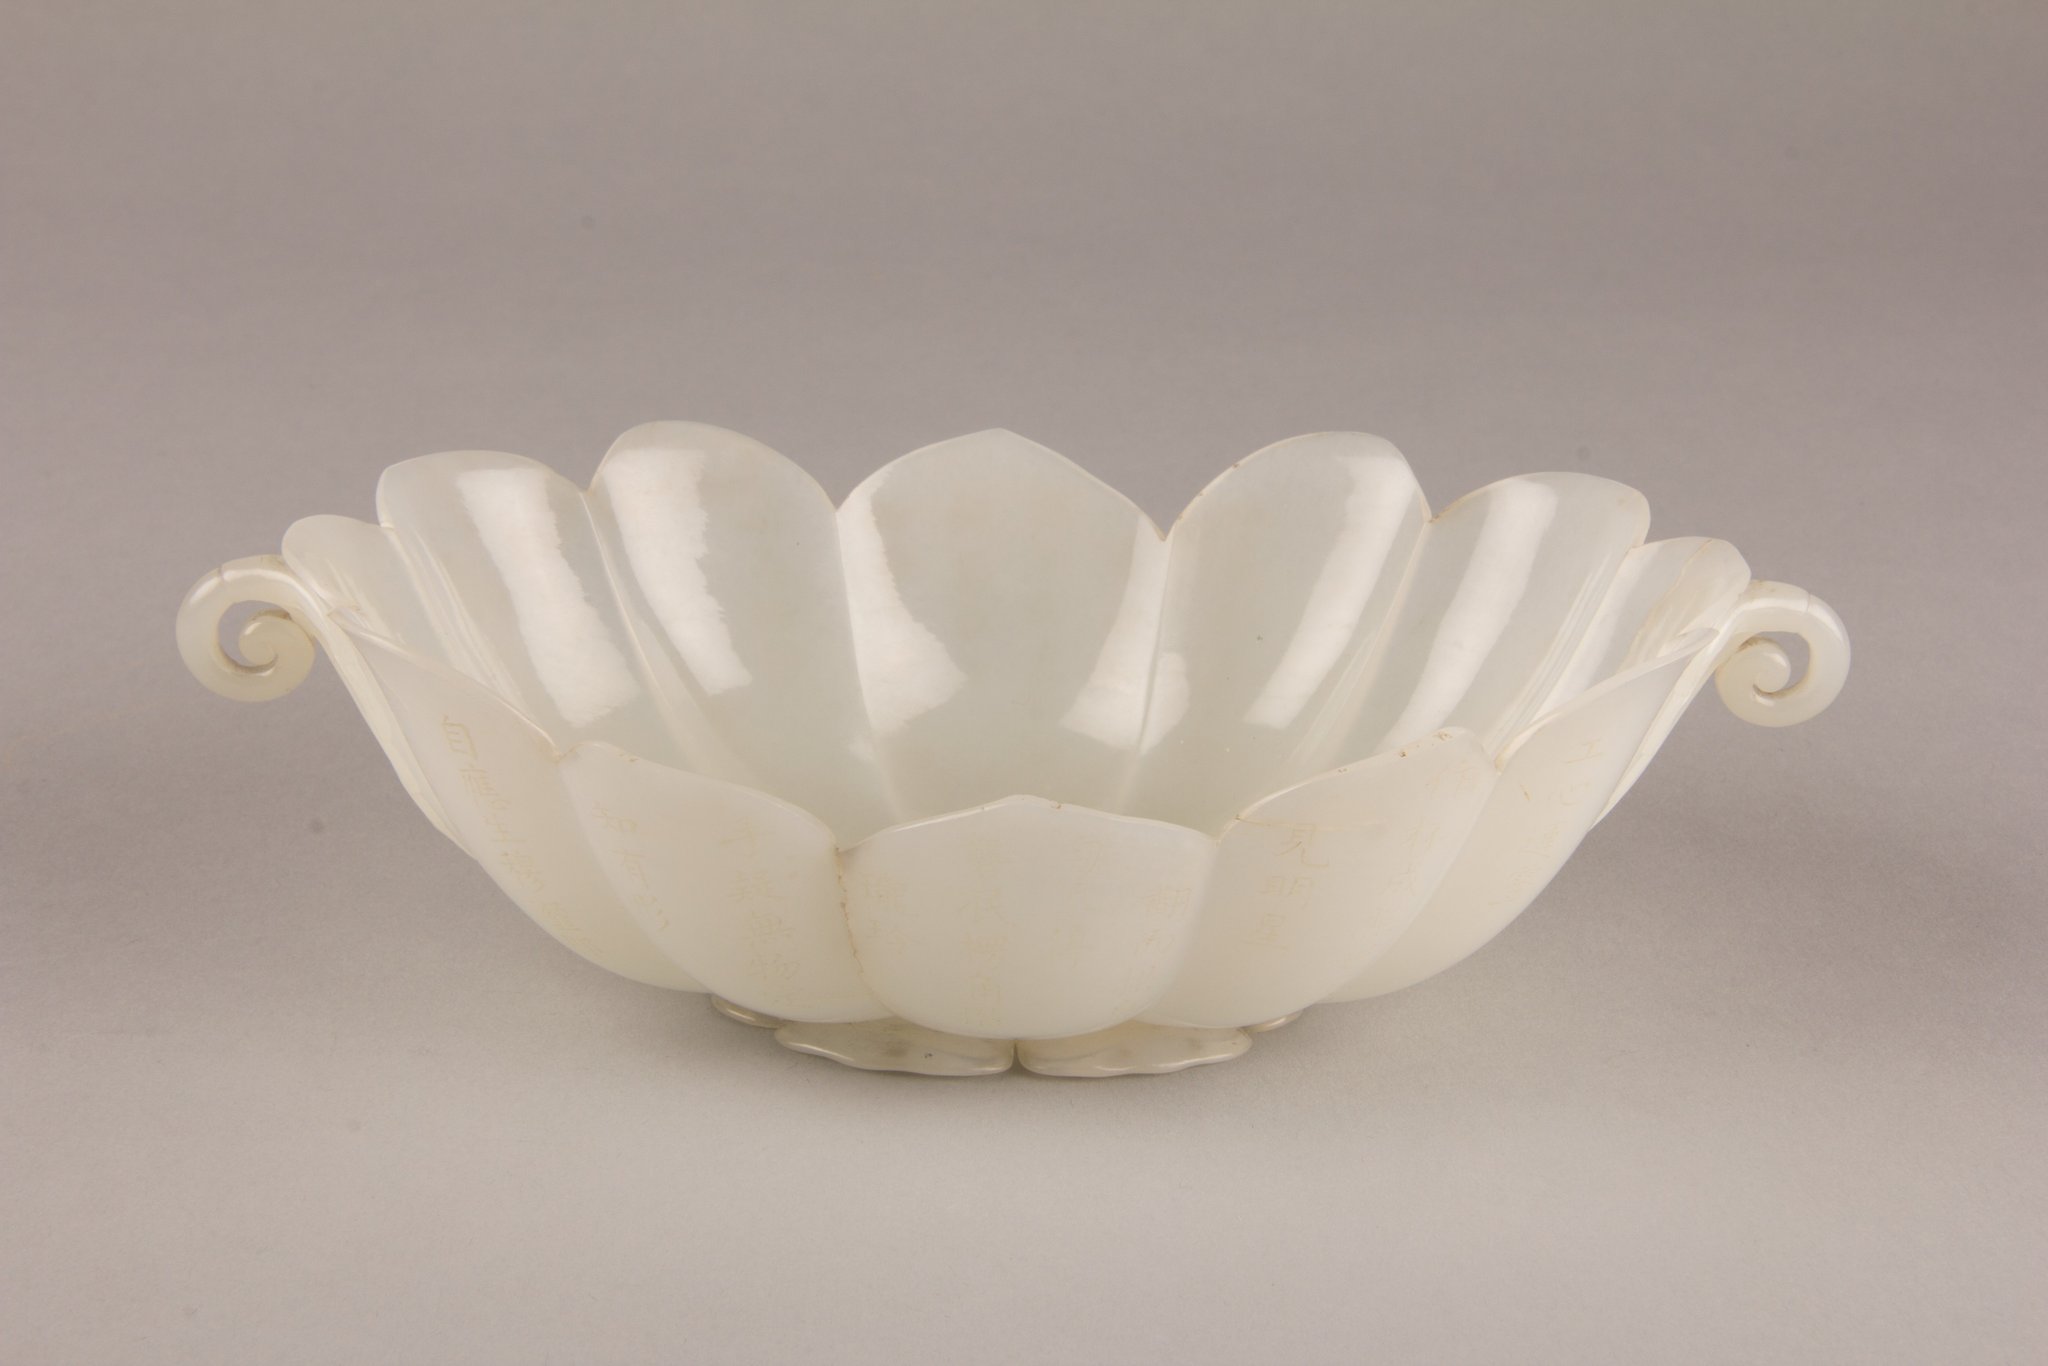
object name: bowl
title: Flower-Shaped Bowl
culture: indian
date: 1601-1800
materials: jade